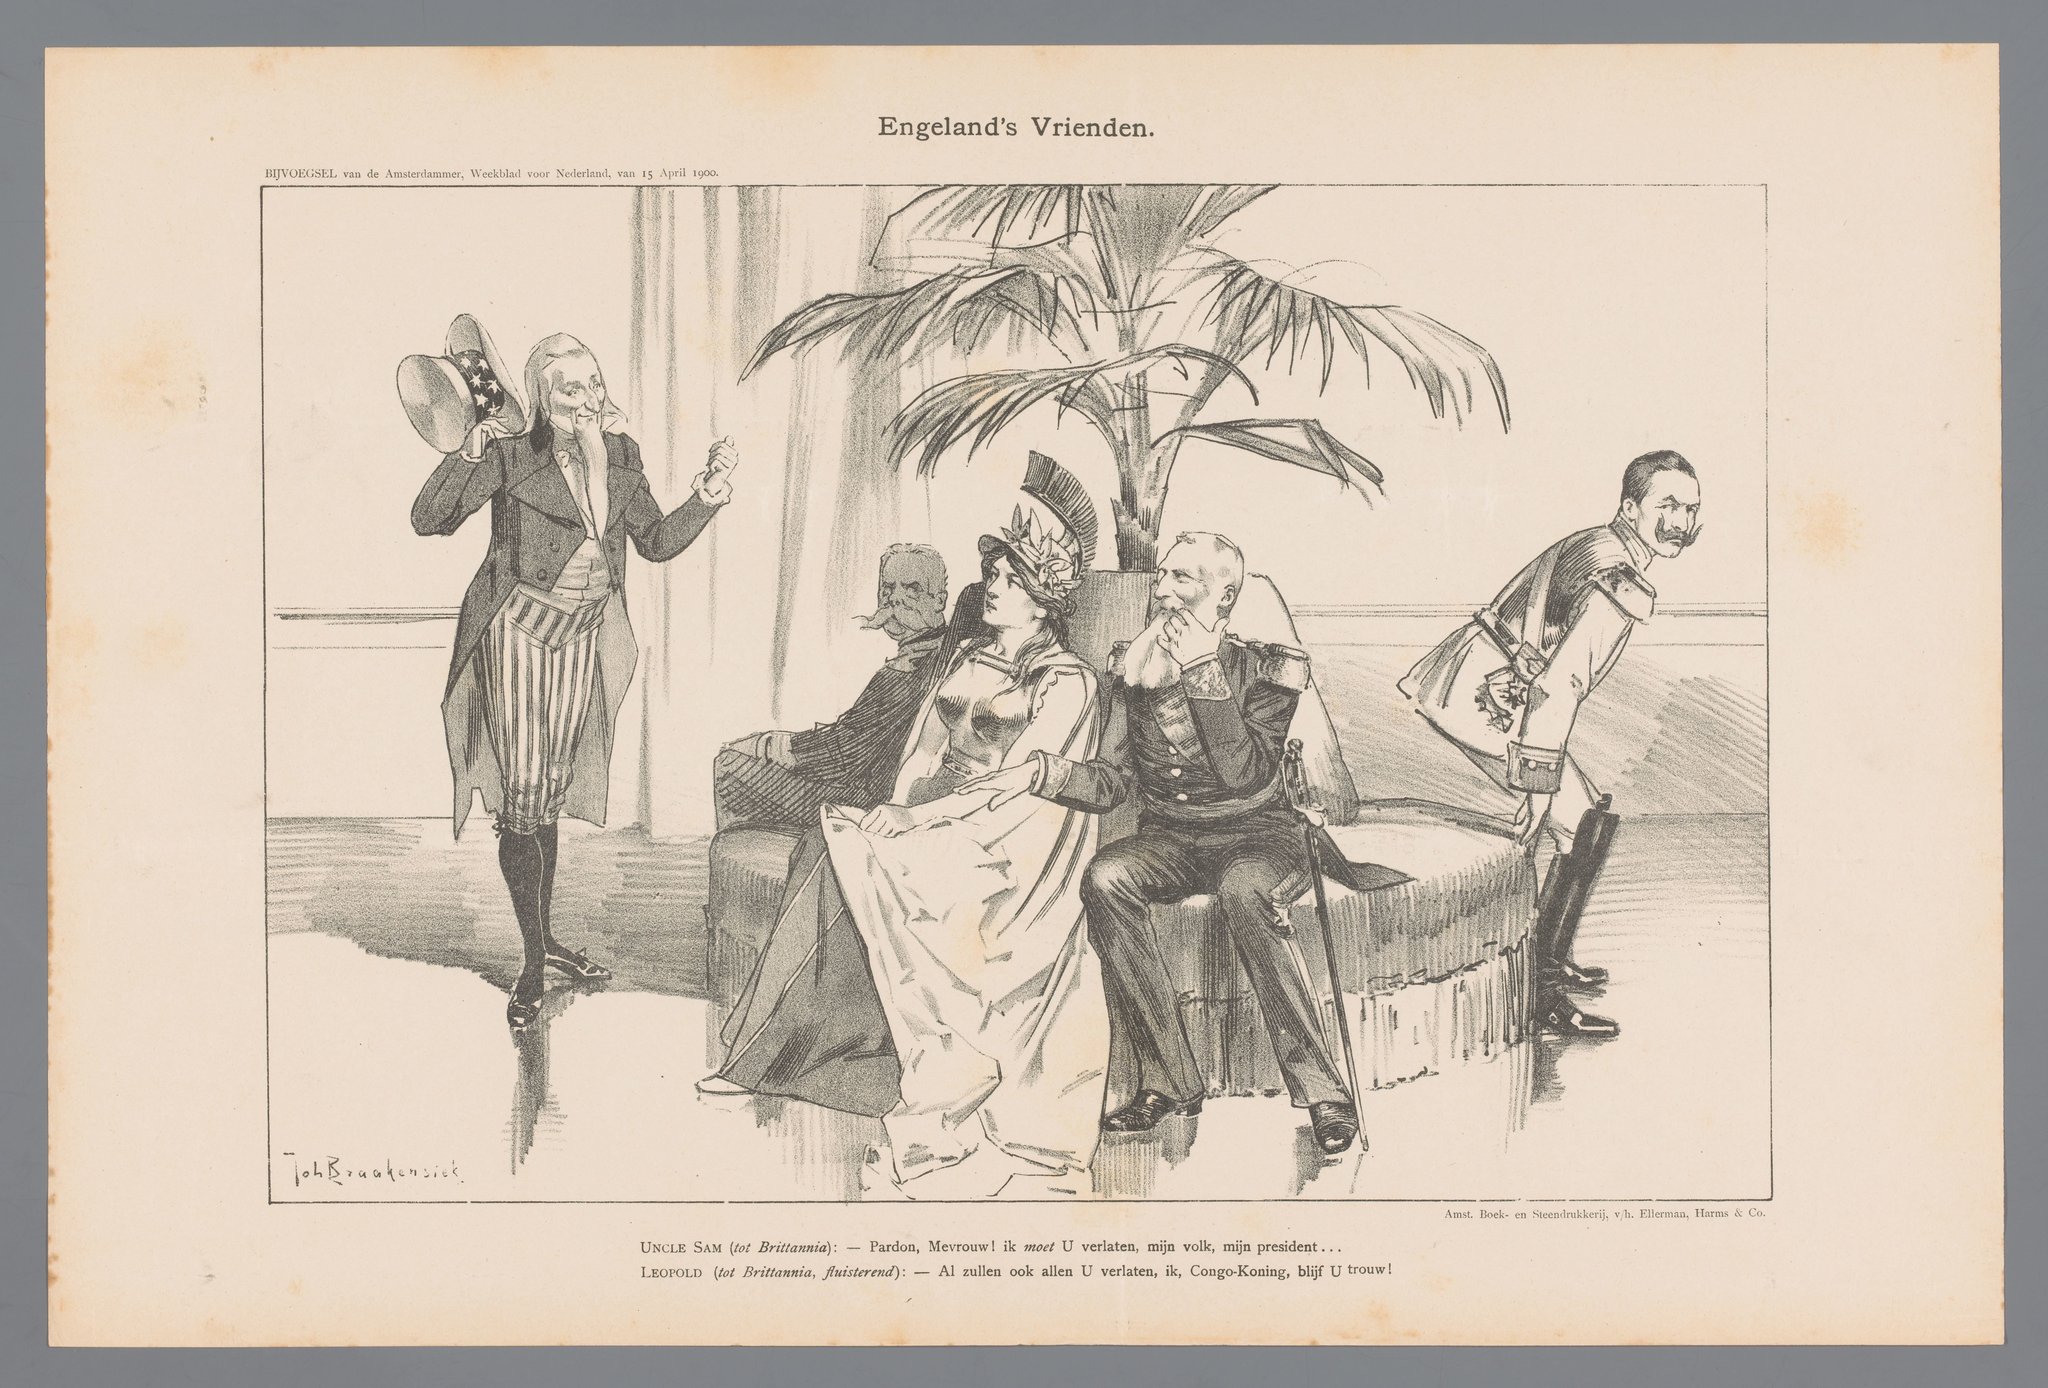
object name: cartoon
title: Engeland's Vrienden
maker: johan braakensiek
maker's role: draughtsman, print maker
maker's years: 1858-1940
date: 1900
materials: paper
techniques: lithograph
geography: amsterdam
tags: leopold ii (koning der belgen), wilhelm ii (keizer van duitsland), personifications of countries, nations, states, districts, etc., historical persons, ruler, sovereign, political caricatures and satires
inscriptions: date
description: Prent uit het bijvoegsel van: De Amsterdammer. Weekblad voor Nederland, 15 april 1900.